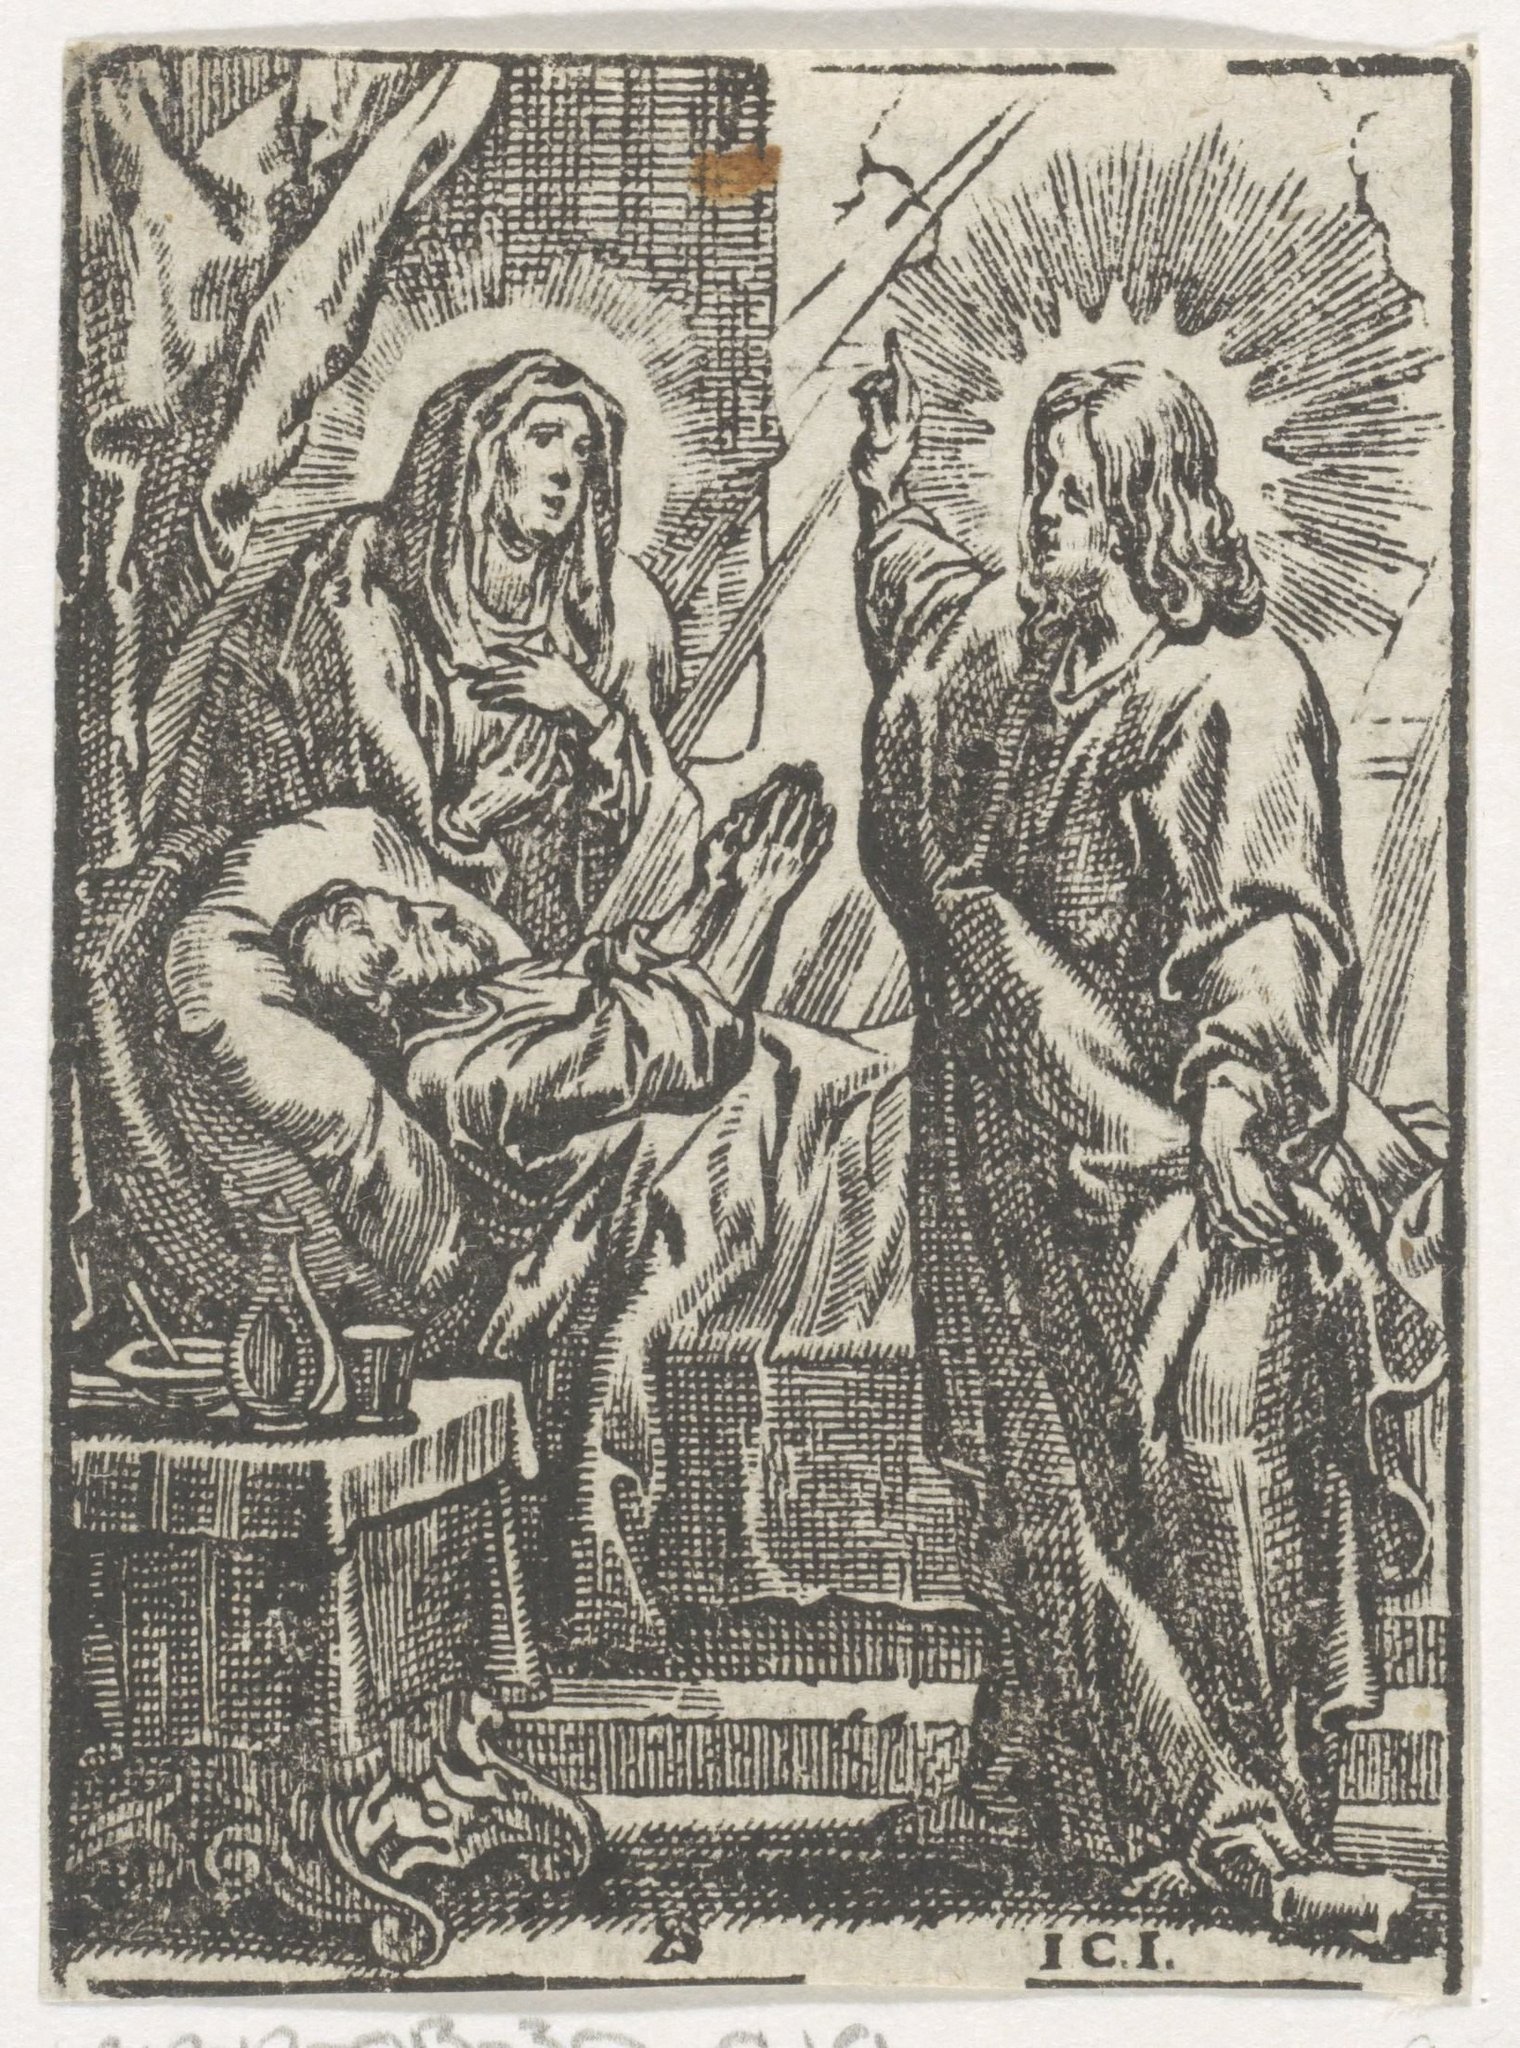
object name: book illustration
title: Christus geneest een zieke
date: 1649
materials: paper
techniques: letterpress printing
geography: antwerp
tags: miracles of christ ~ healing the sick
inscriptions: collector's mark: Lugt 2228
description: Prent uit: Andries, Judocus. Perpetua crux sive passio Jesu Christi. Antwerpen: Cornelis Woons, 1649.